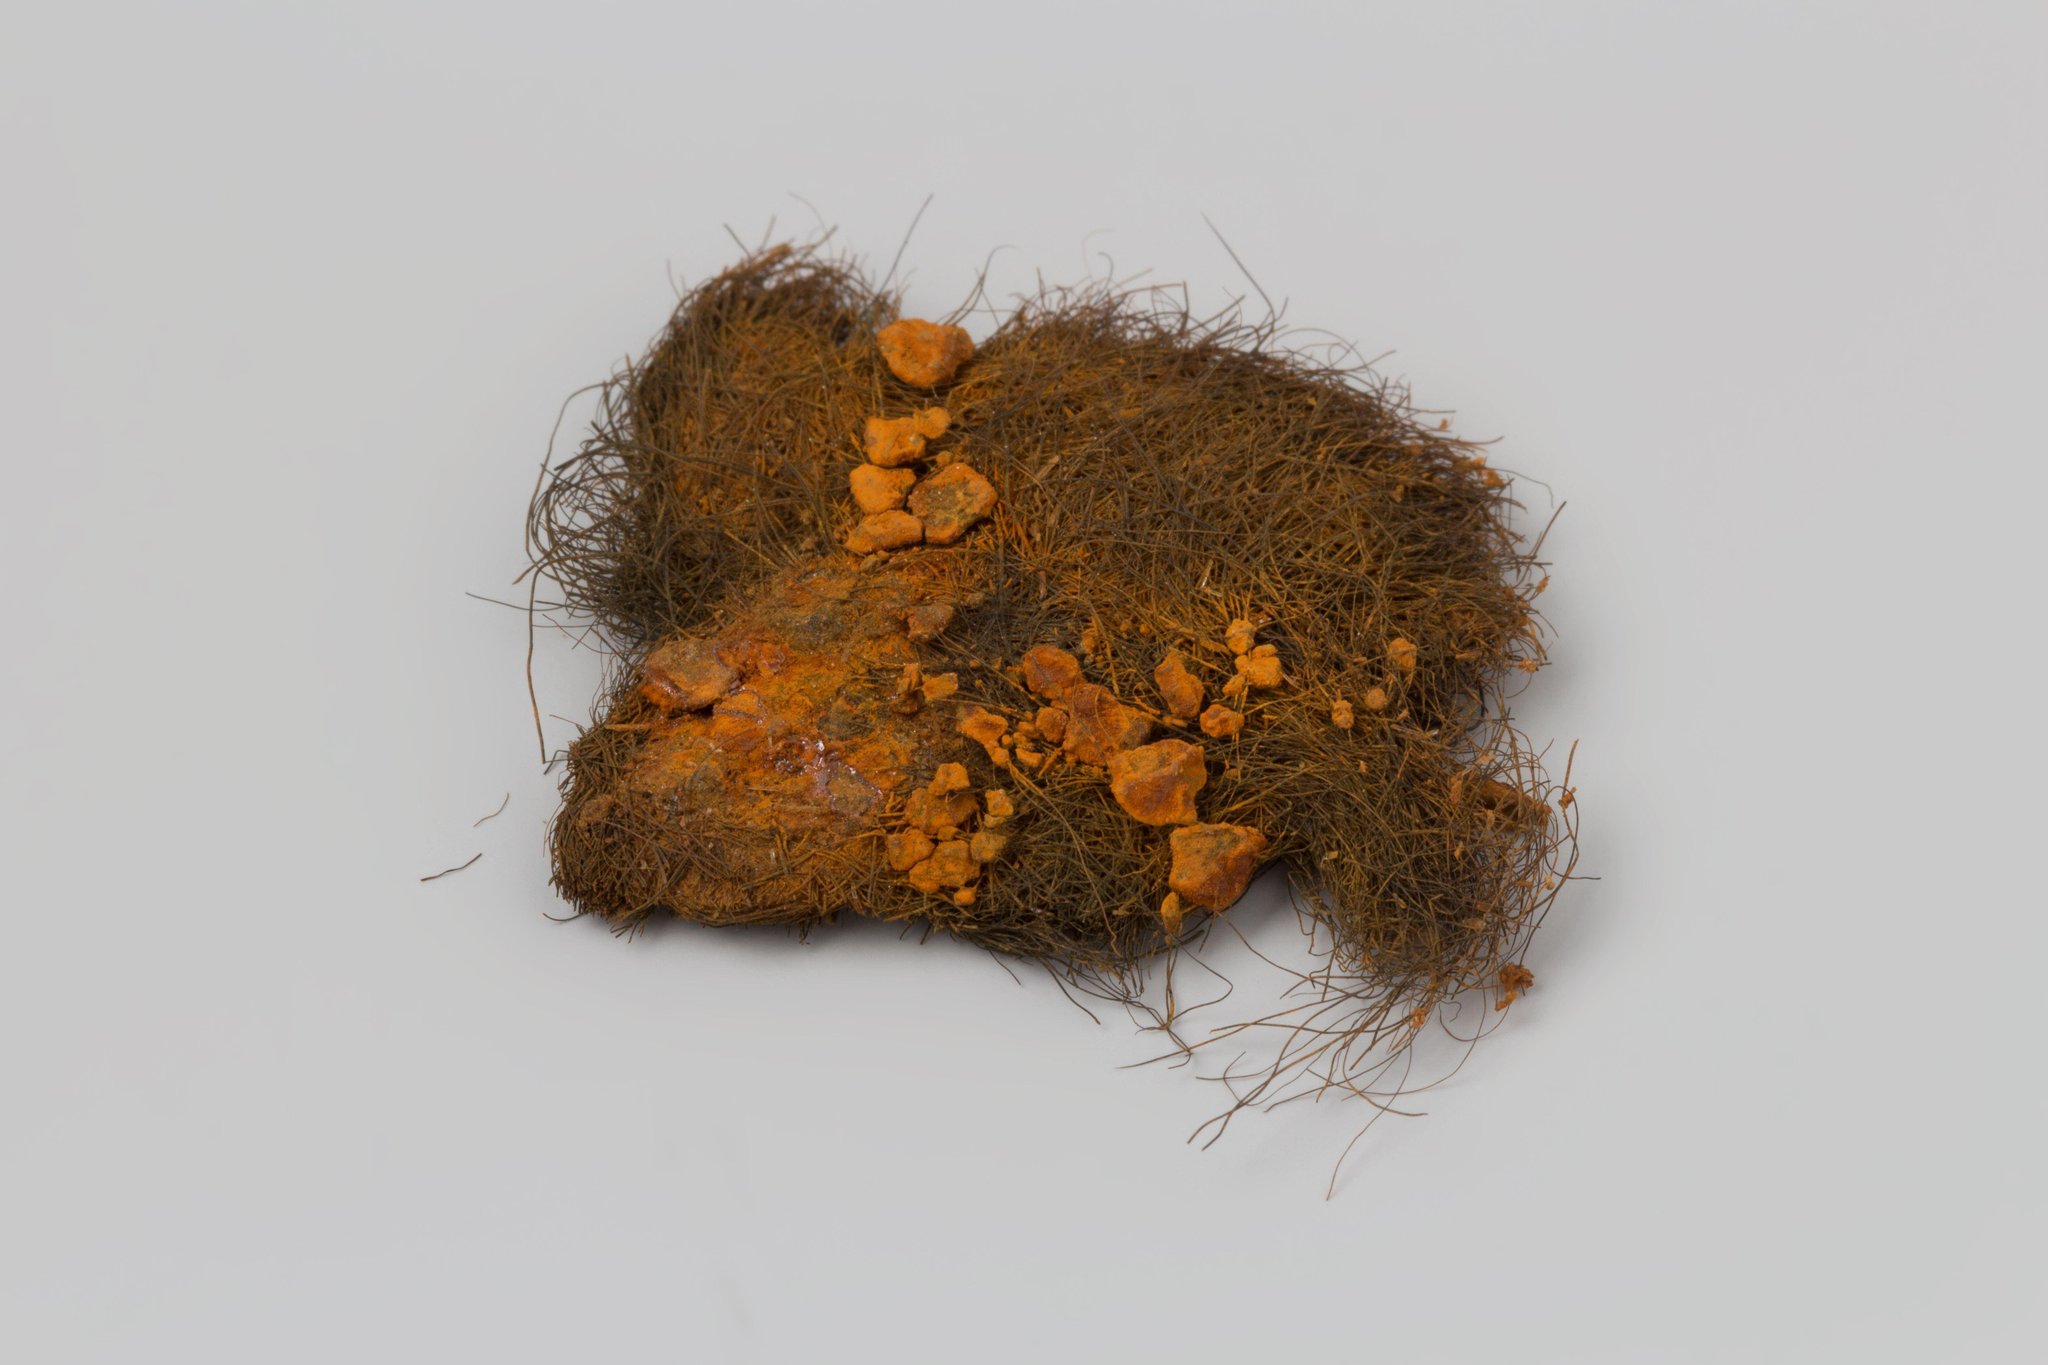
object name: hair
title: Fragmenten van koehaar uit het wrak van de in 1735 vergane Oost-Indiëvaarder 't Vliegend Hart, vermoedelijk breeuwsel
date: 1700-1735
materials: hair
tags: 't vliegend hart (schip), verenigde oostindische compagnie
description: Het fragment is een plat vierkantje bestaande uit losse, samengeperste koeharen. Deze haren werden gebruikt naden te dichten/breeuwen. Het is oranje van kleur, als gevolg van roestvoering.